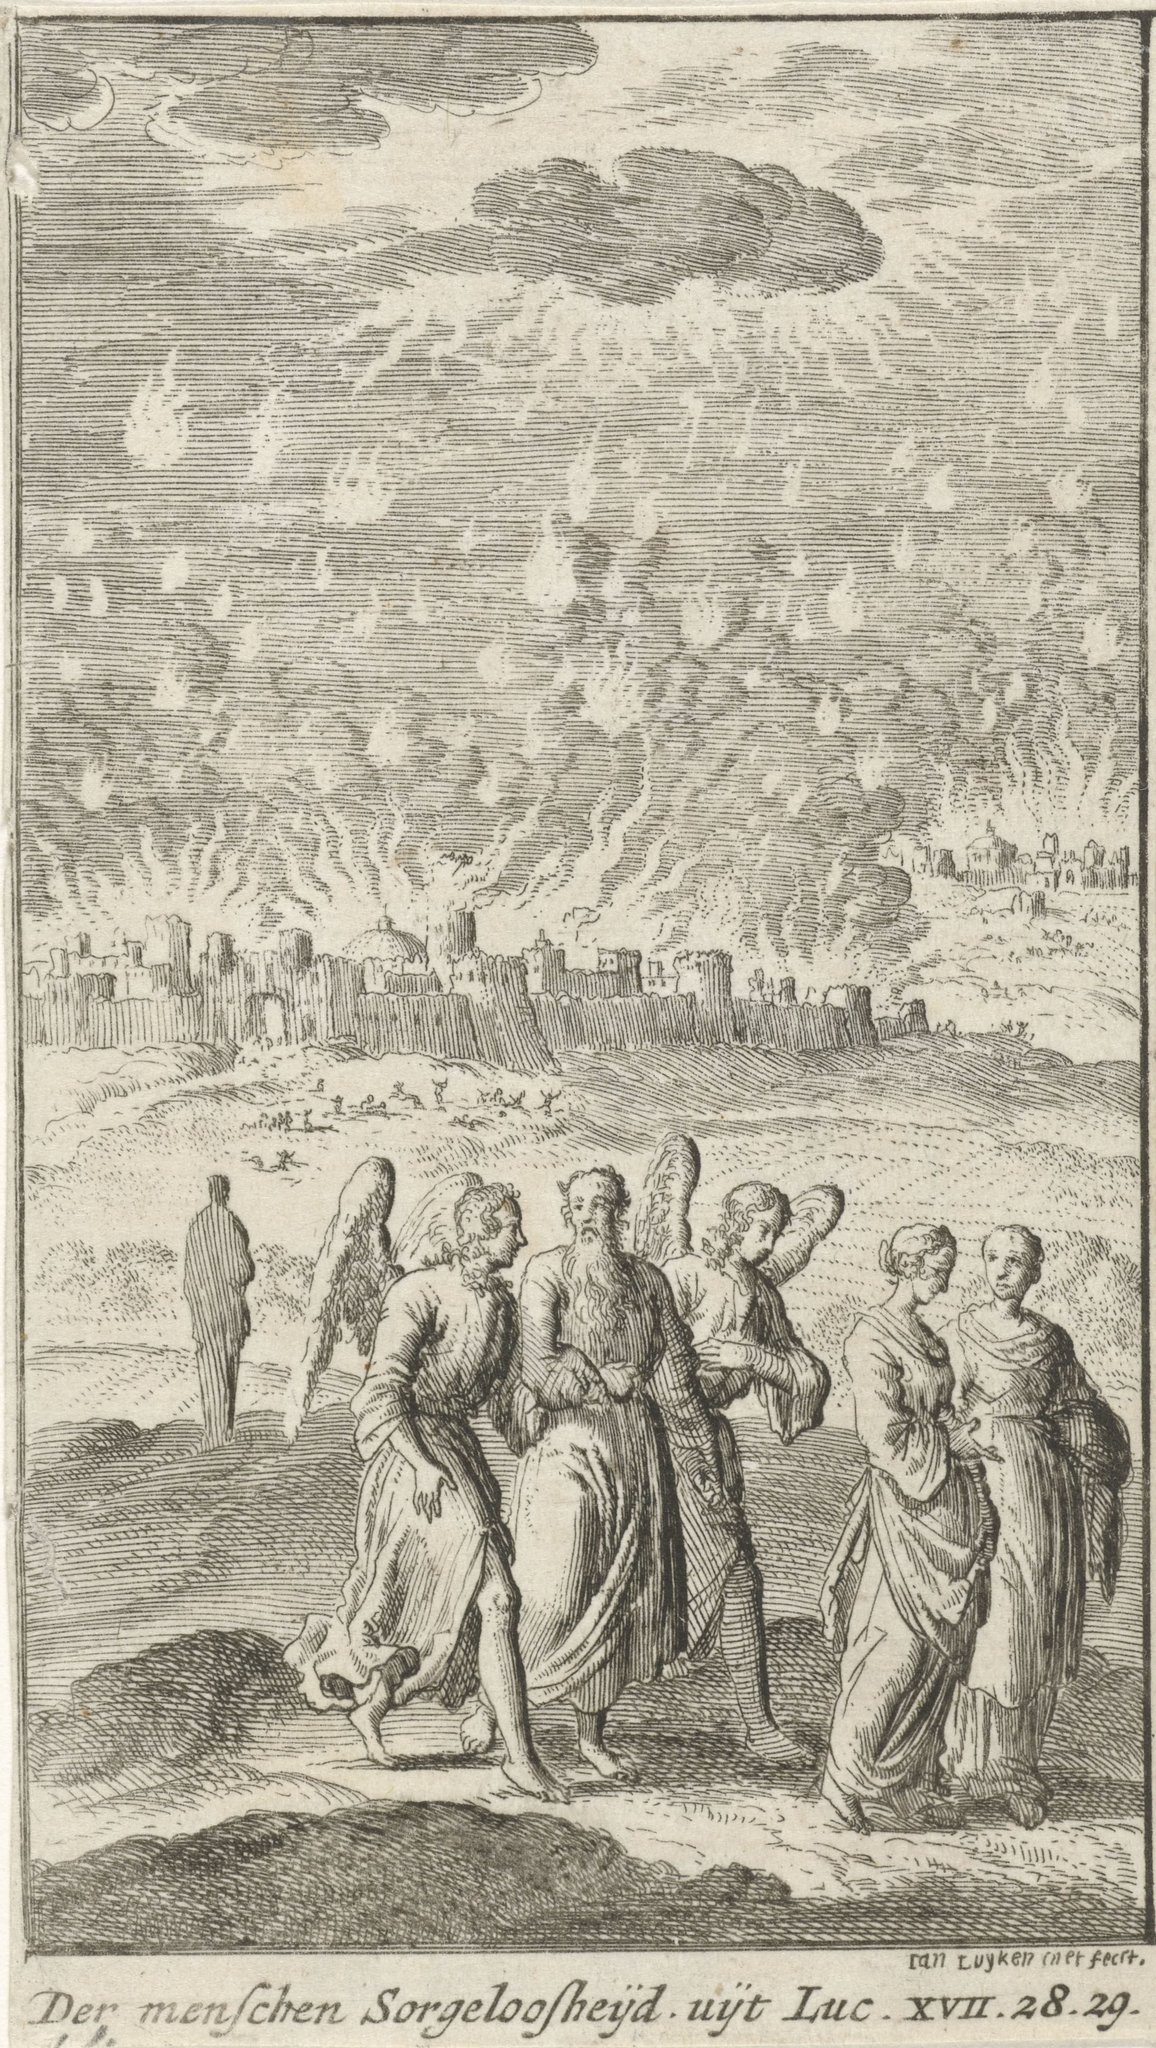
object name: print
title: Vierentwintig scènes uit het Nieuwe Testament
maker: jan luyken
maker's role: draughtsman, print maker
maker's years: 1649-1712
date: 1727-1729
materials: paper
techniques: etching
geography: amsterdam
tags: the destruction of sodom and gomorrah: lot and his family flee to zoar, carrying their belongings; an angel may be showing the way (genesis 19:24-29)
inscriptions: collector's mark: Lugt 240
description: Prent opgenomen in: Het Nieuwe Testament ofte alle Boecken des Nieuwen Verbondts onses Heeren Iesu Christi. Dordrecht: Pieter en Jacob Keur, 172X (niet voor 1727). In dit werk is de complete vierentwintigdelige serie opgenomen. De prenten werden, hetzij alle tezamen, hetzij gedeeltelijk, veel gebruikt tot versiering van Nieuwe Testamenten en verschenen tevens in kopie.